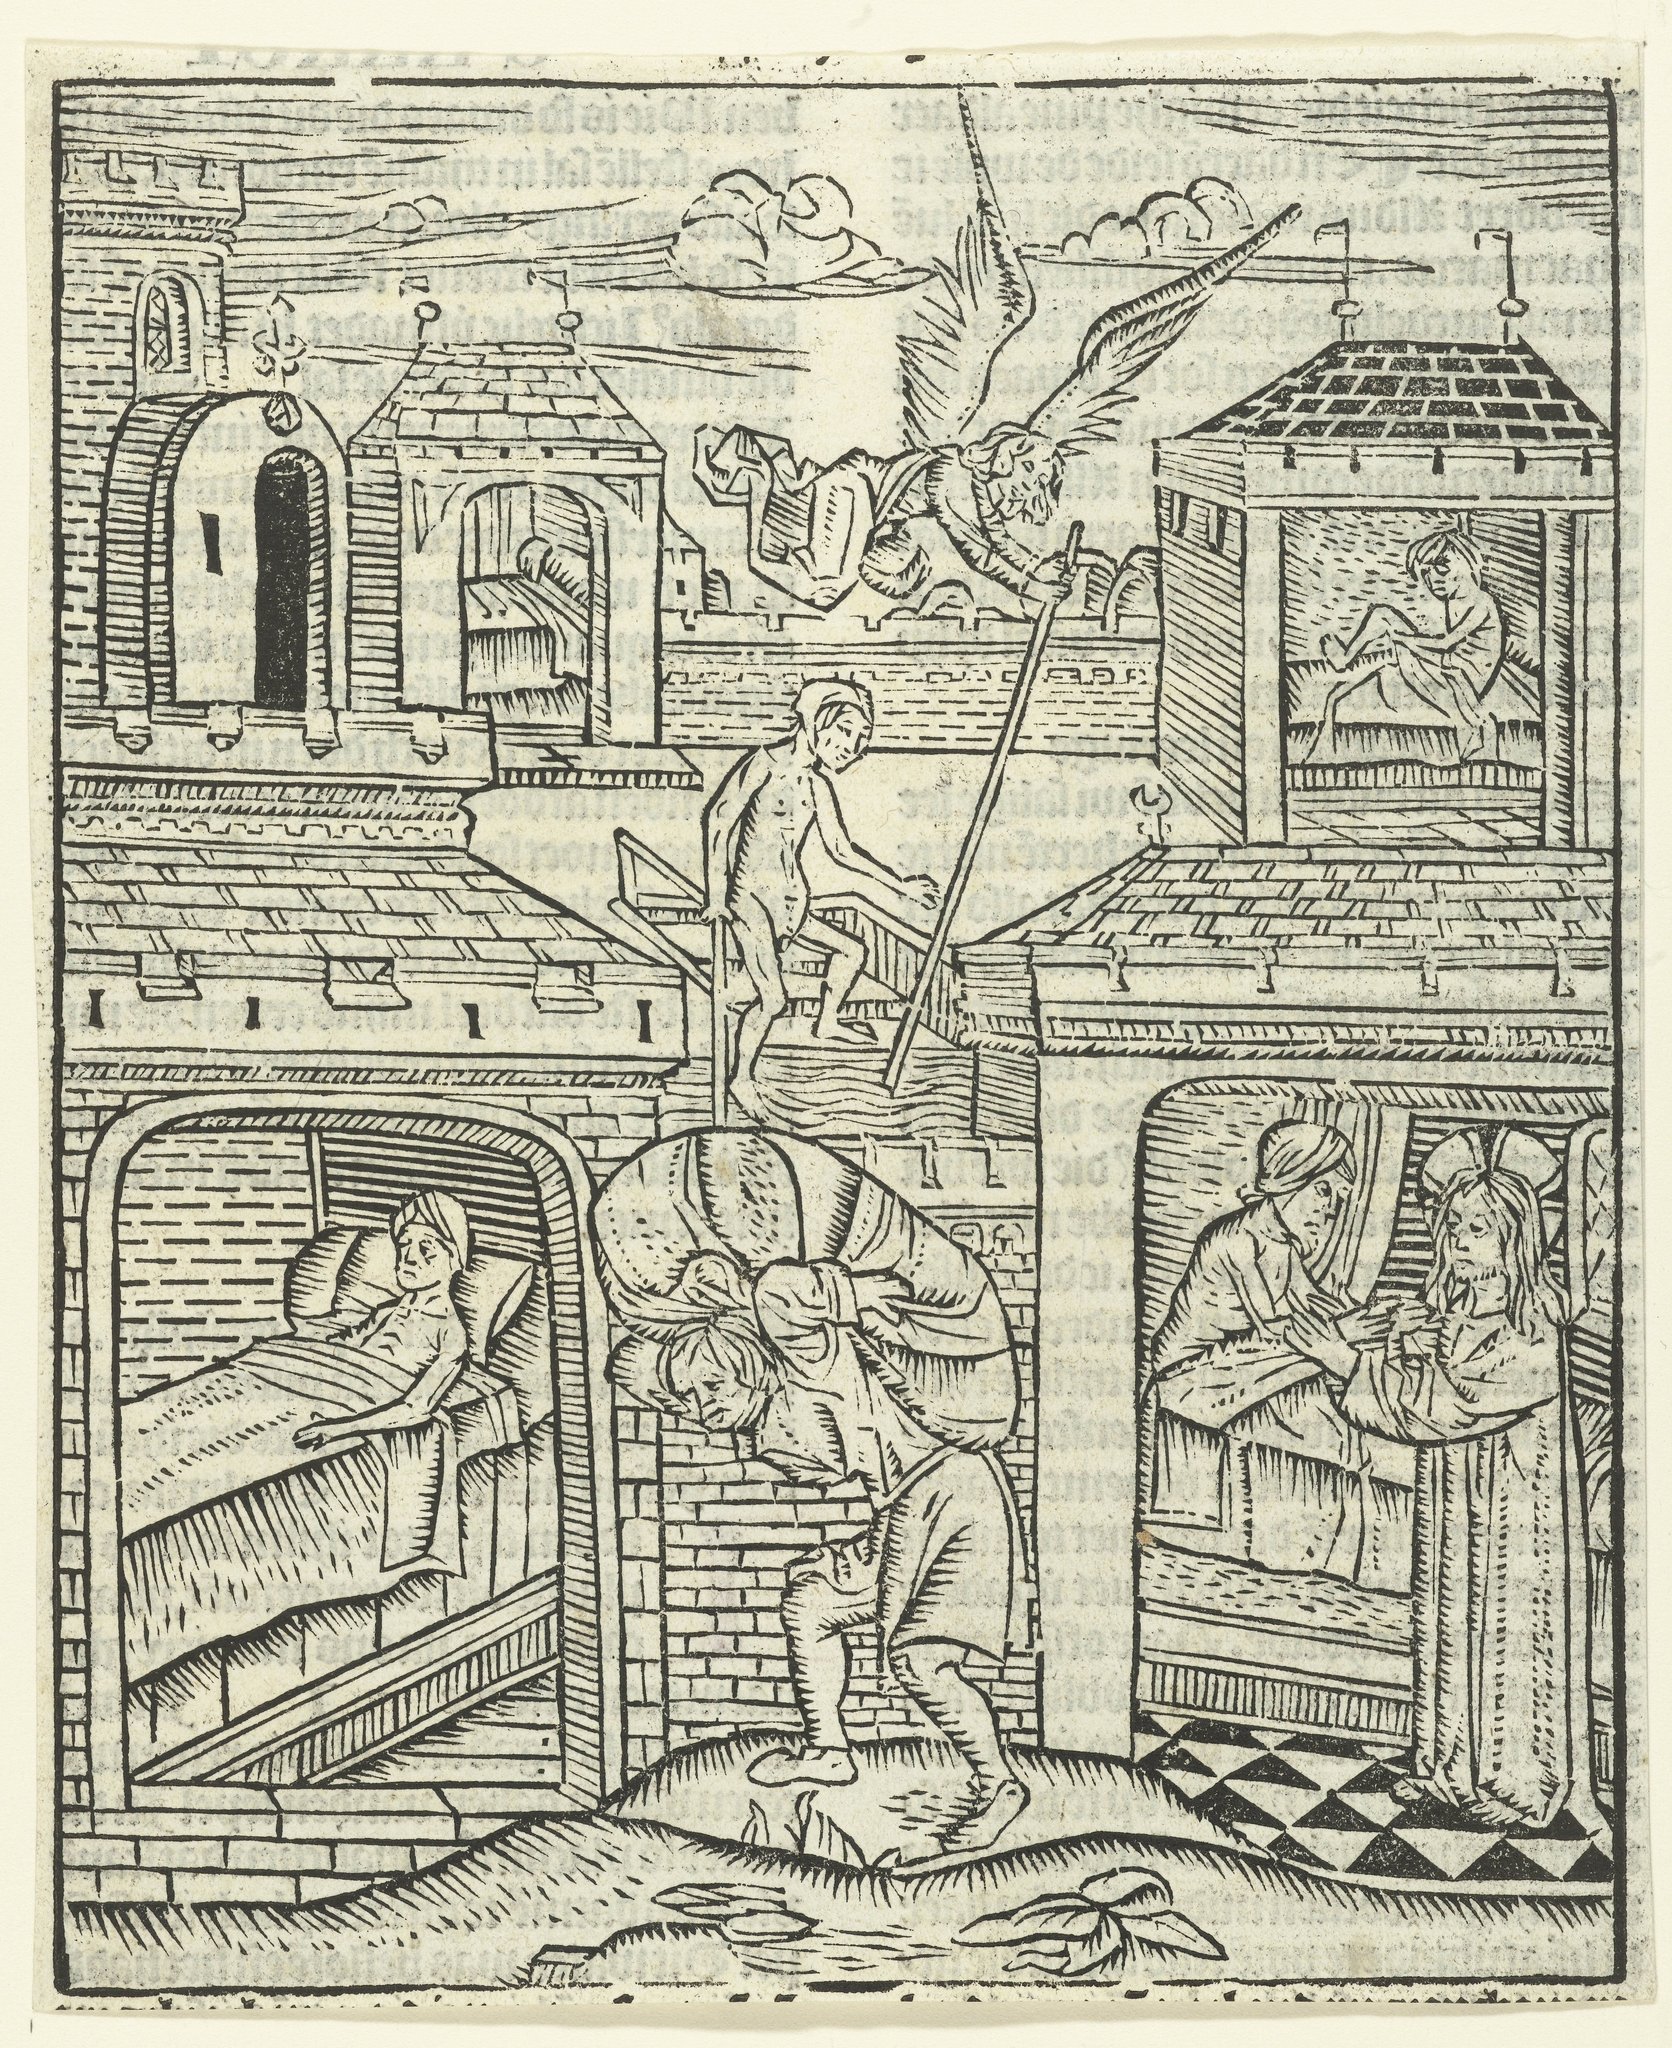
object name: print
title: Christus geneest een man bij het bad van Betesda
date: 1480-1500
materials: paper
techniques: woodcut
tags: disabilities, deformations, the sick try to reach the water of the pool of bethesda, christ says to a paralytic man: 'rise, take up your pallet (bed)', an angel stirs up the water of the pool of bethesda, the paralytic man is cured and walks away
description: Eén blad van 113 uit Ludolphus de Saxonia, "Dit es dleué ons liefs heeren ihesu christi". Anonieme Nederlandse vertaling. Uitgegeven door Henrick Eckert van Homberch te Antwerpen in 1503. Botke, K. Deze 113 houtsneden, die meestal reeds in vroege Nederlandse boeken gebruikt zijn, worden toegeschreven aan de tweede Meester van Delft, de Meester van de Delbecq-Schreiber-passie en de Meester van de Virgo inter Virgines. In Conway (1884) en in "De gulden passer"(1951) zijn ook eerdere versies opgenomen. Botke, K.